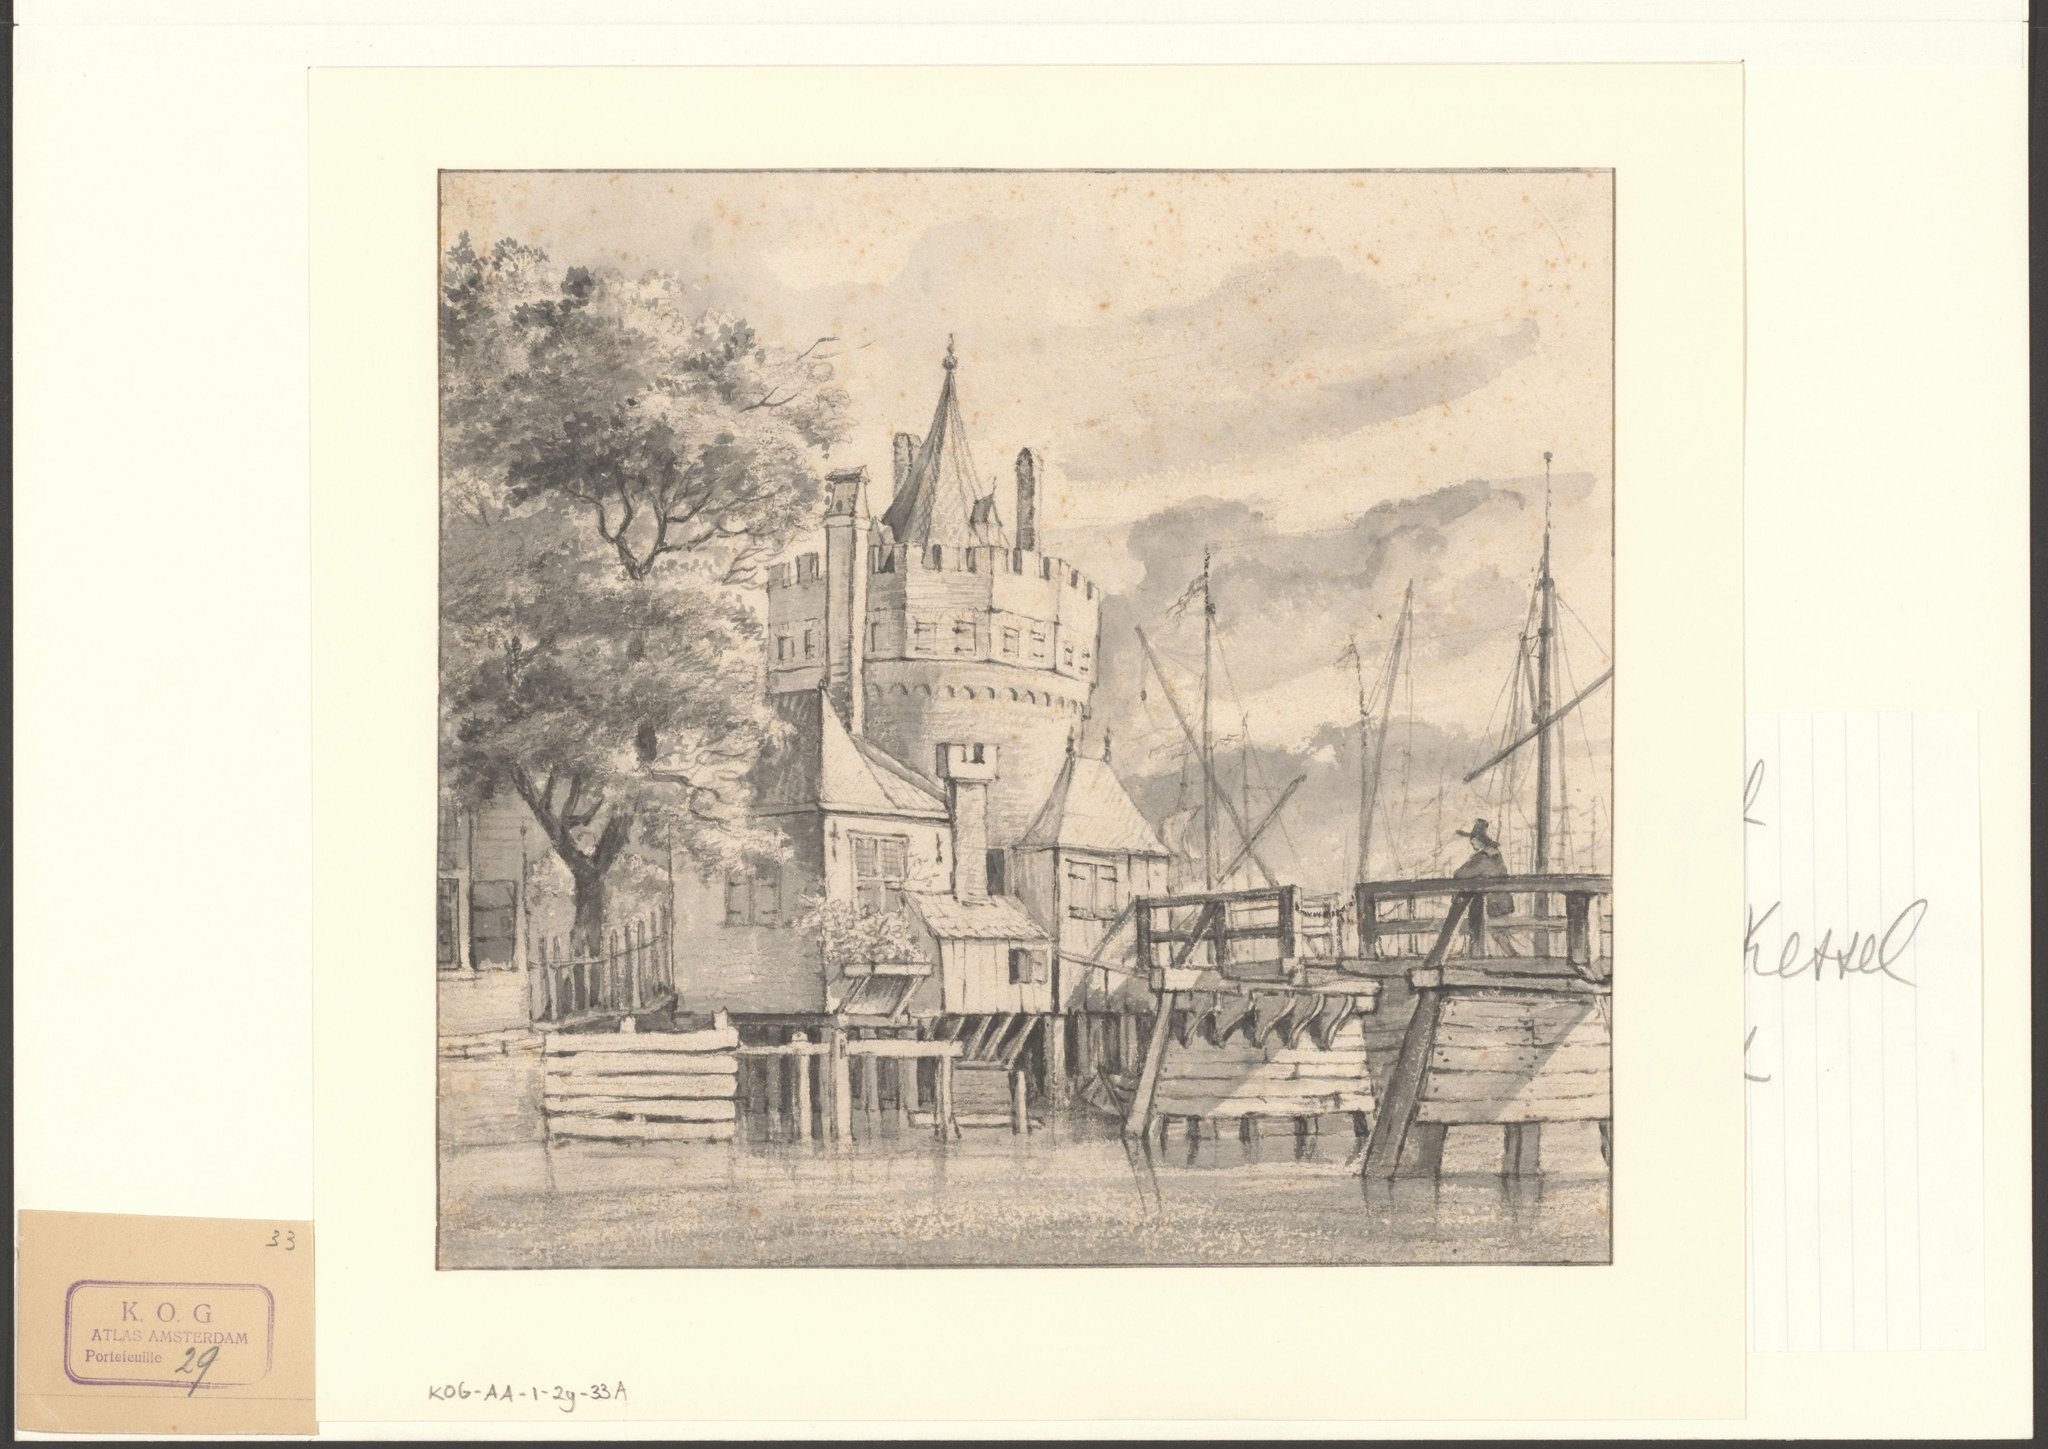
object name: drawing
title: Gezicht op de Schreierstoren gezien vanaf de Geldersekade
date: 1670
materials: chalk, ink, paper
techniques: brush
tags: city-view in general; 'veduta', towers ~ fortified city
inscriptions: inscription: ‘Jan van Kessel fe"t anno 1670’, inscription: ‘Mej. Freri[...]s zegt / tekening van Van Kessel / is van Hulswit’, collector's mark: ‘29’ Lugt 1641b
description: Onderwerpsrubriek binnen de Atlas Amsterdam: Schreierstoren.